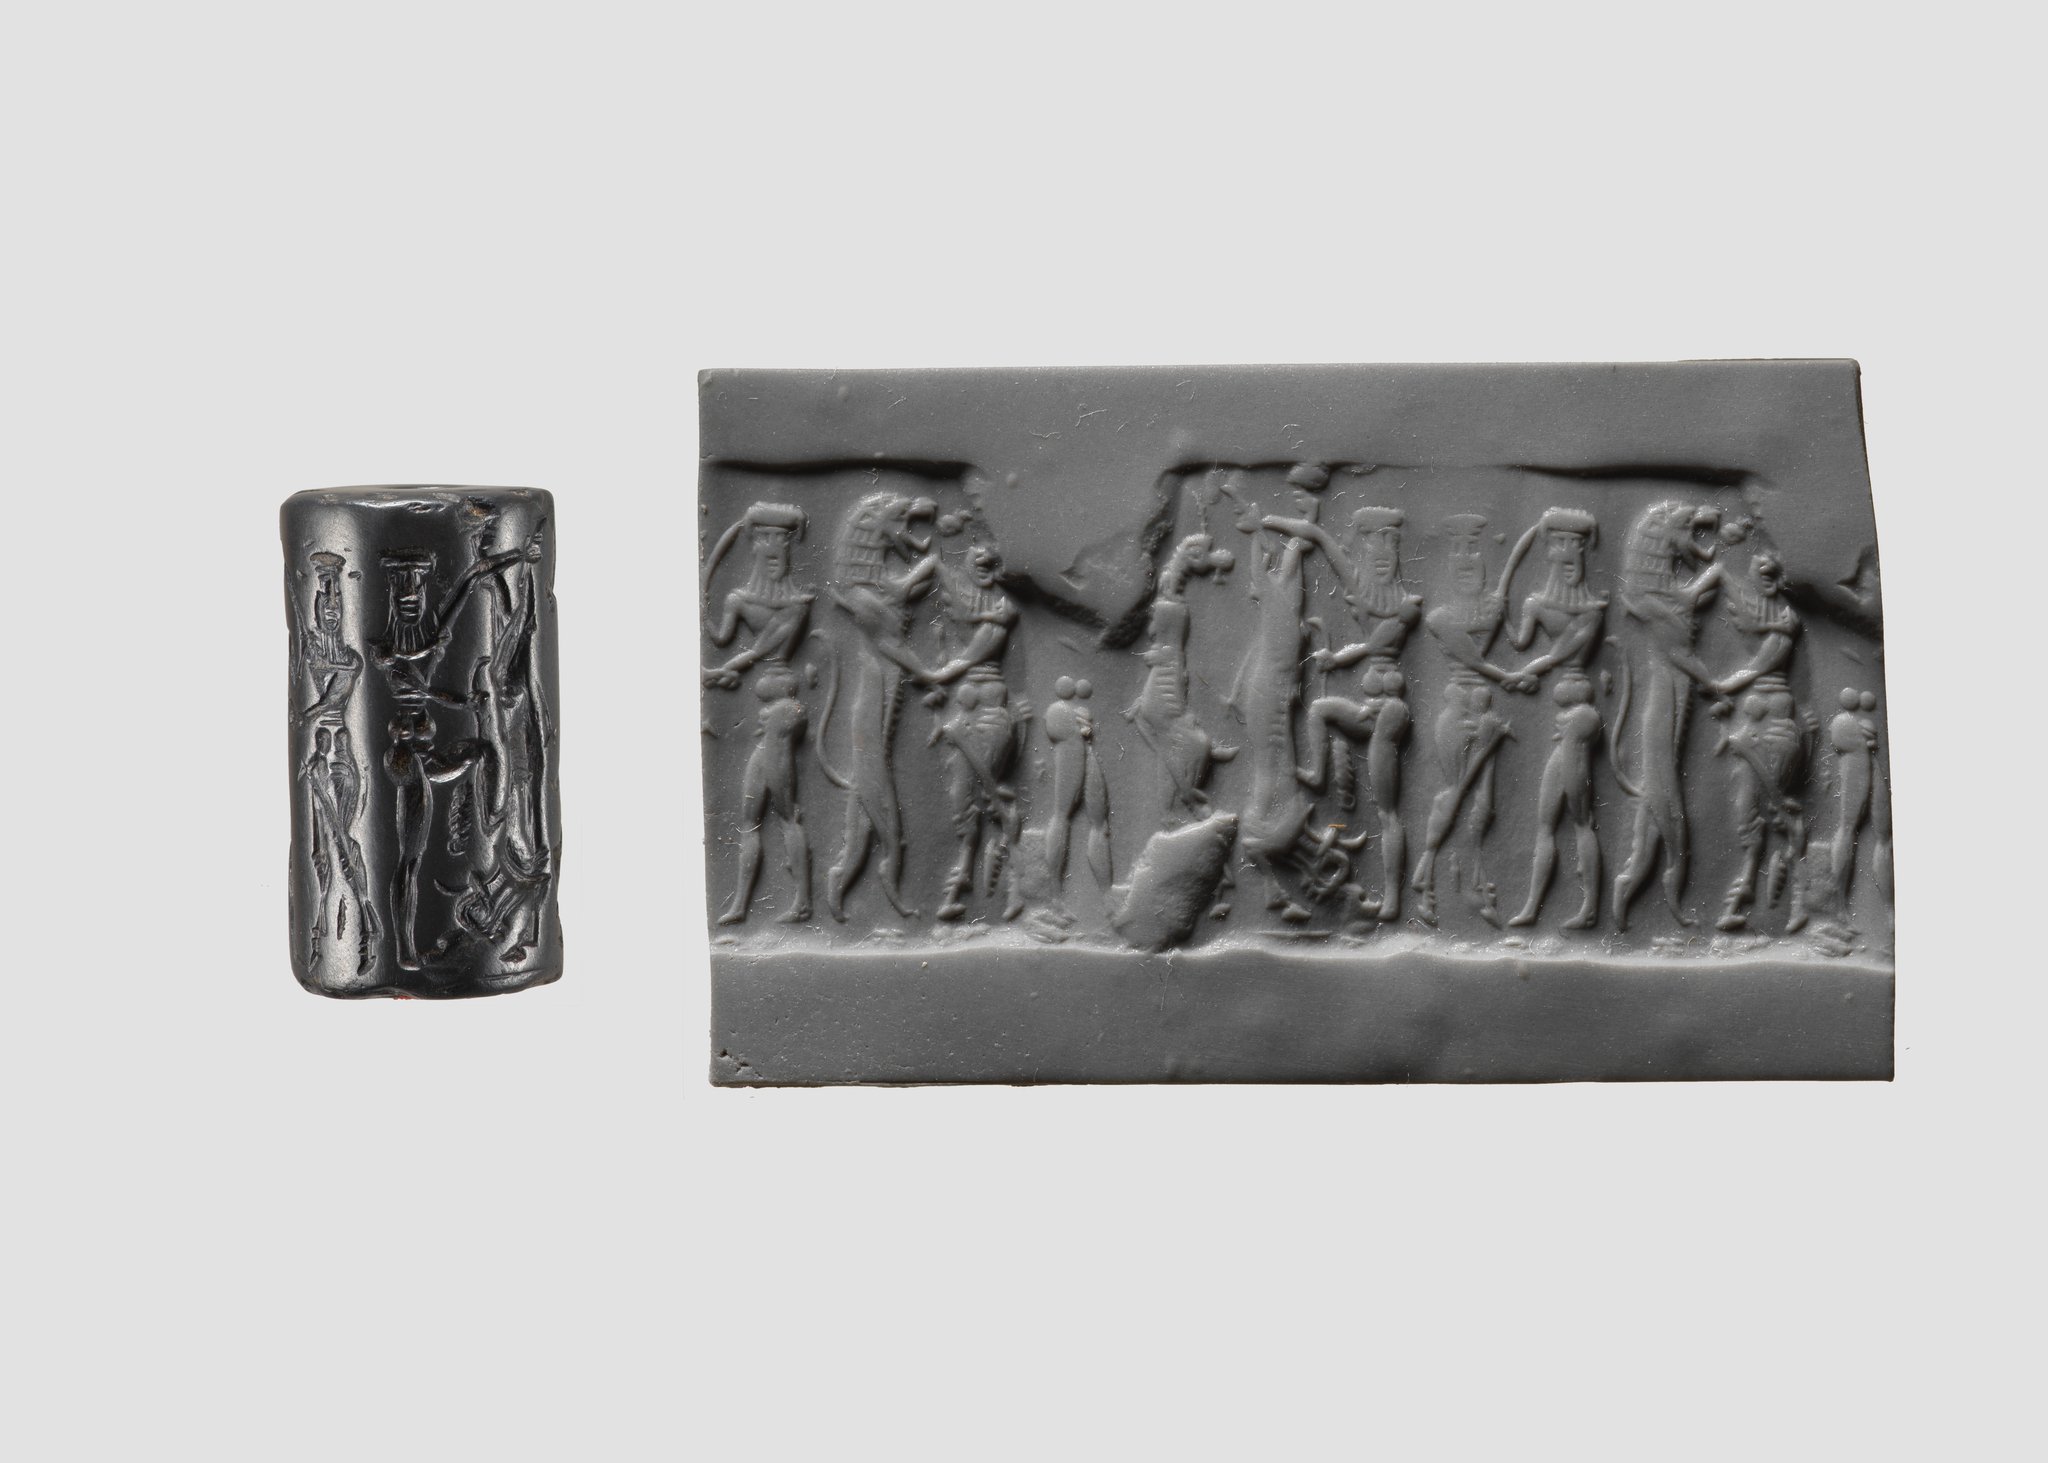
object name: cylinder seal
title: Cylinder seal with human and animal contests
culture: akkadian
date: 2350-2150 BCE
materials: mineral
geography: mesopotamia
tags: animals